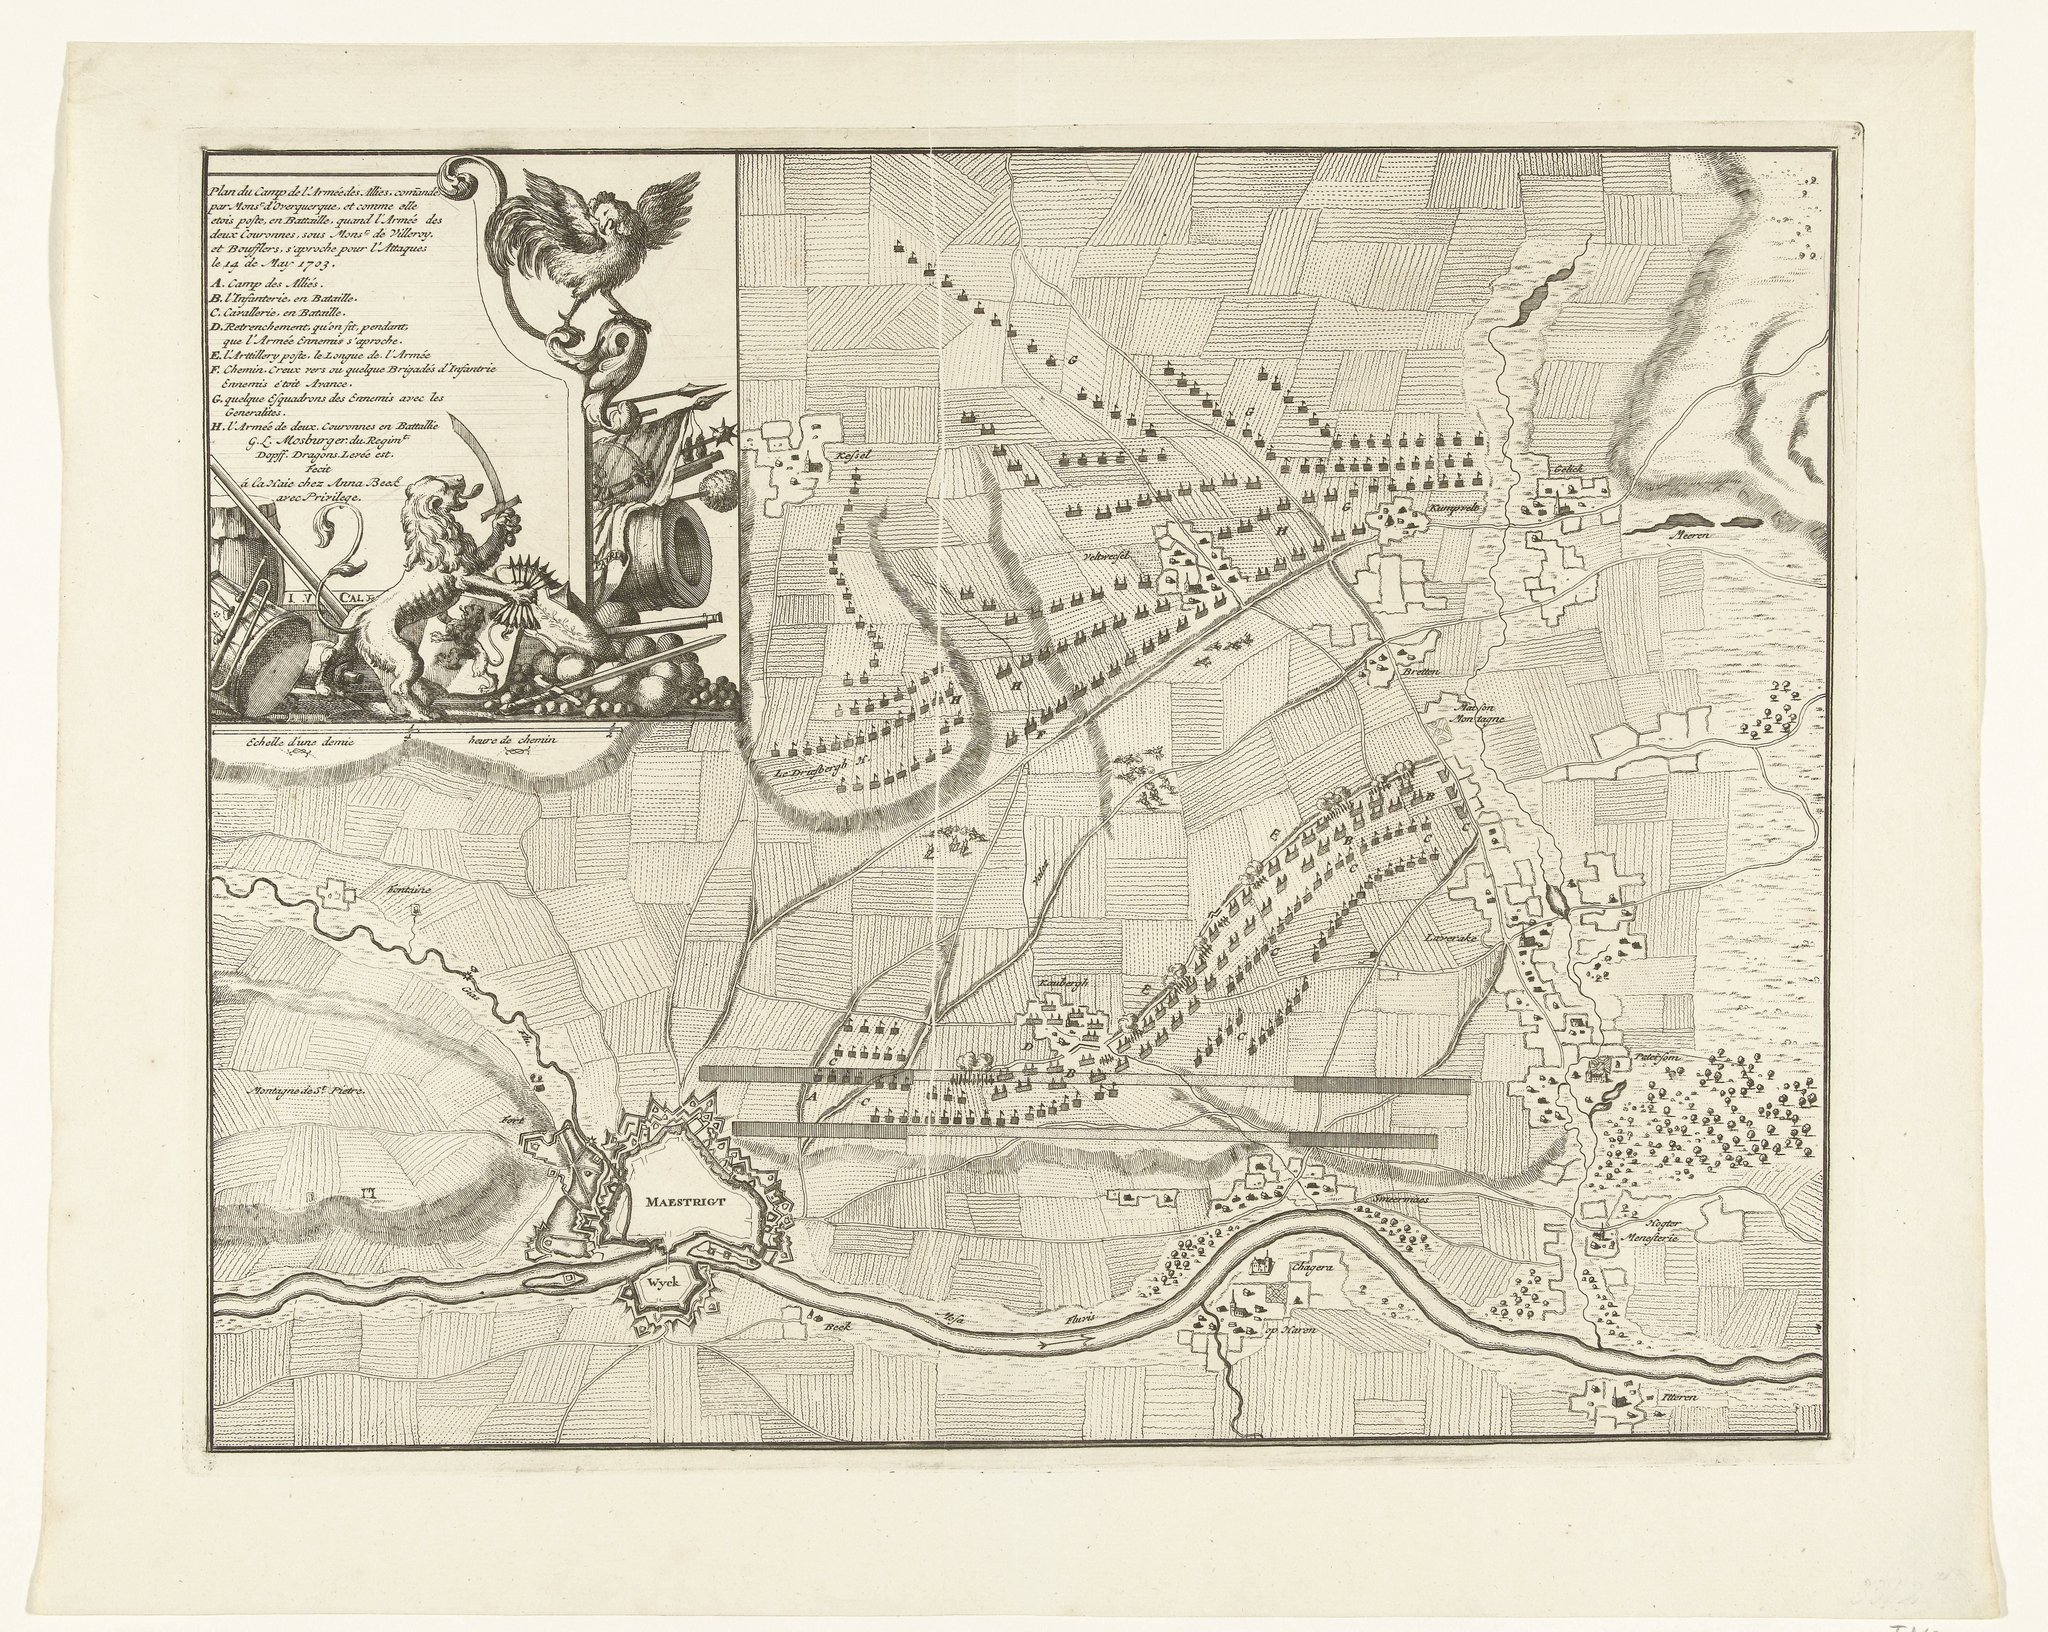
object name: print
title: Plan du Camp de l'Armée des Allies, com[m]ande par Monsr. d'Overquerque (...) 14 de May 1703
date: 1703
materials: paper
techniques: etching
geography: northern netherlands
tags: maps of separate countries or regions, siege, position war, maastricht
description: Kaart met het plan van het legerkamp van de Geallieerden onder de Graaf van Ouwerkerk voor Maastricht, 14 mei 1703. Linksboven een cartouche voor de legenda A-H met de Hollandse Leeuw die de Franse Haan met wapens bedreigt.